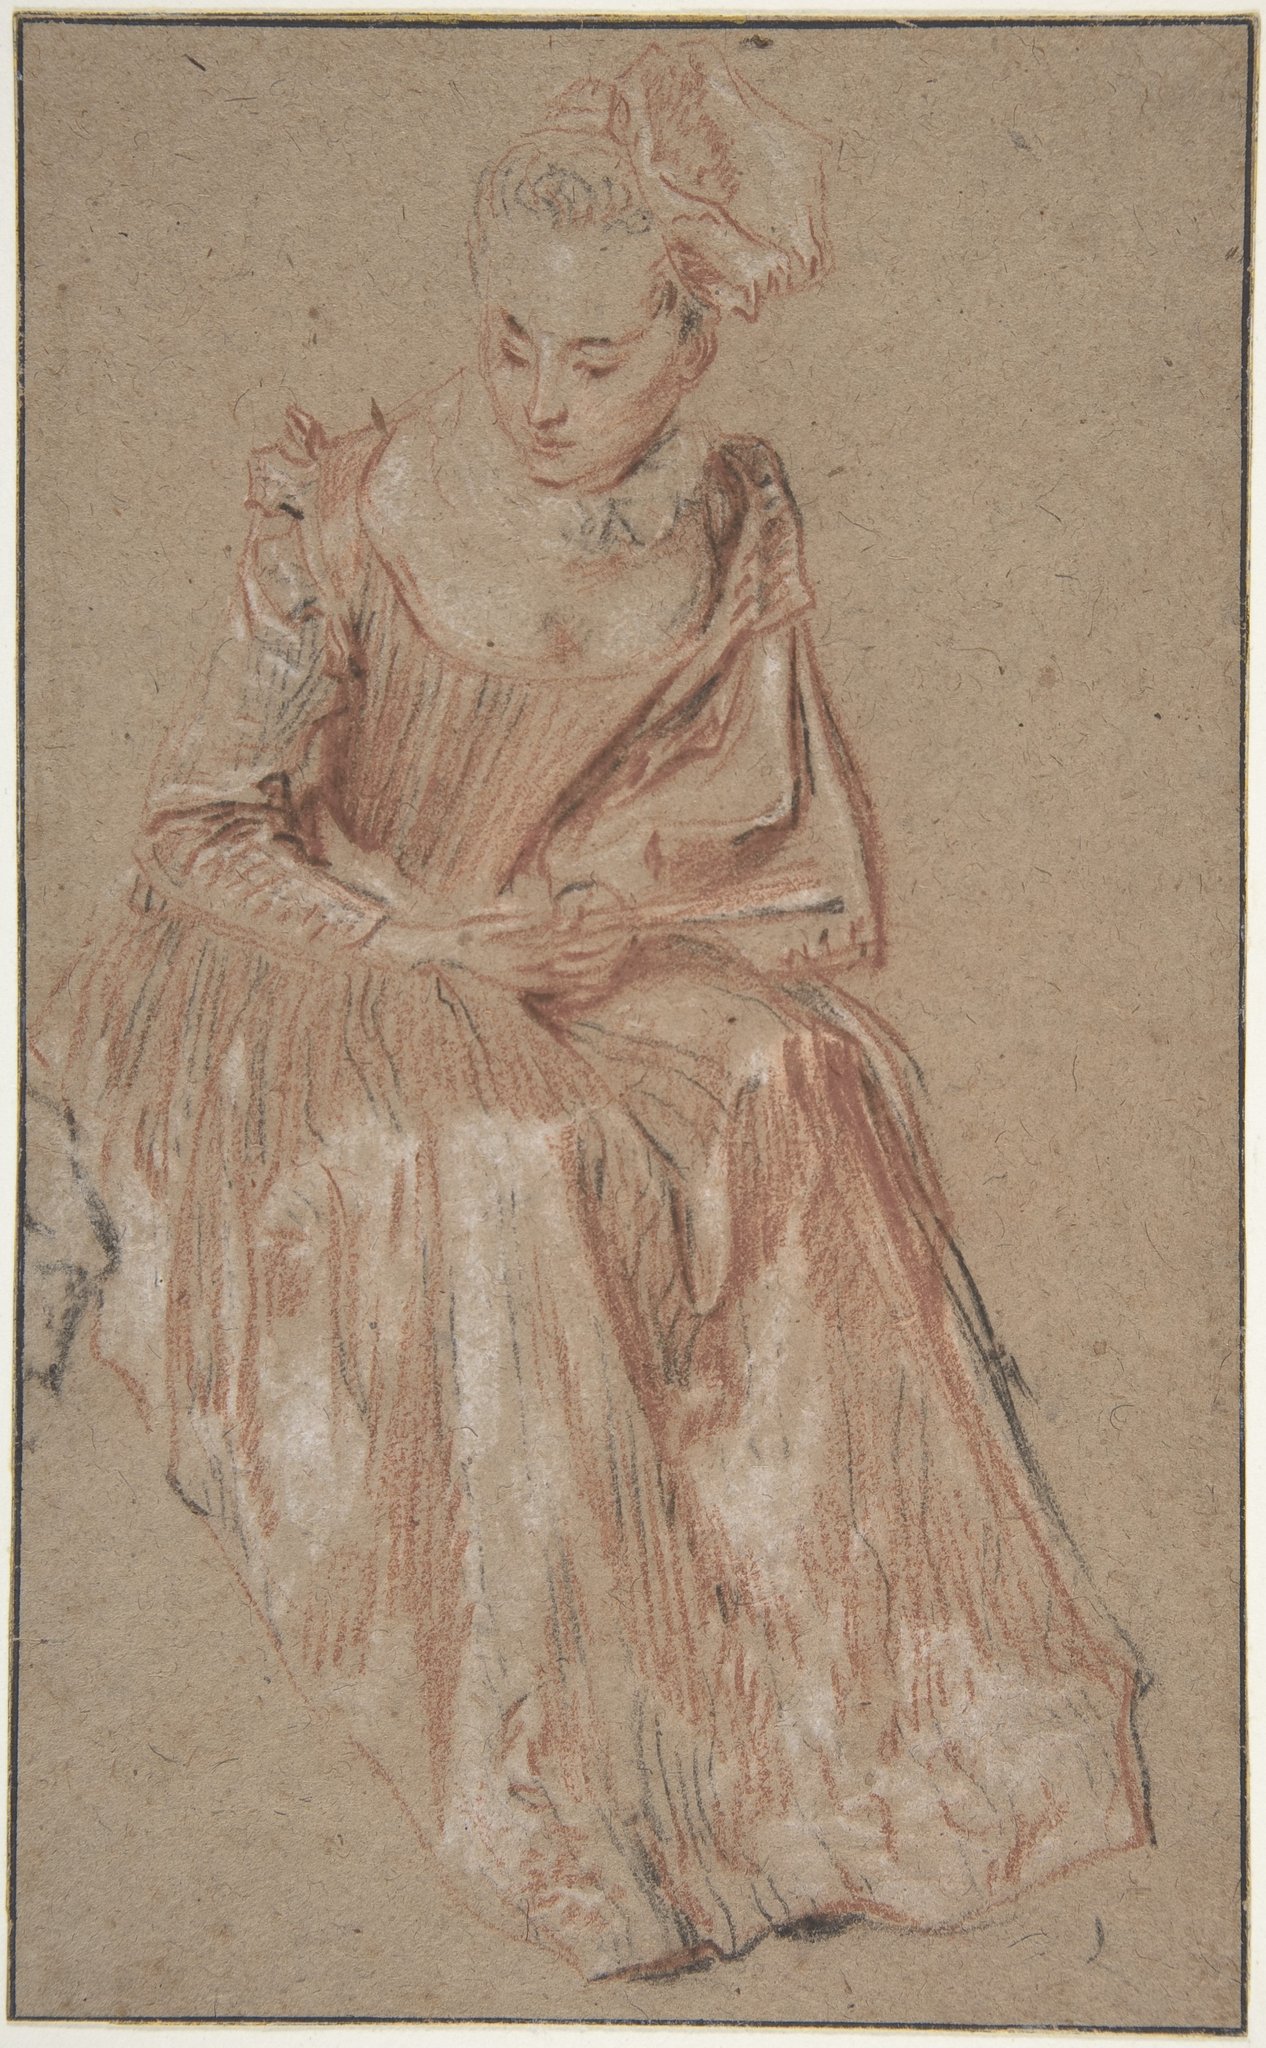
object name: drawing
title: Seated Woman Holding a Fan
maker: antoine watteau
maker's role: artist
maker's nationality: french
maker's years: 1684-1721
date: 1717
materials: chalk, ink, paper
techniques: pen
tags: fans,women